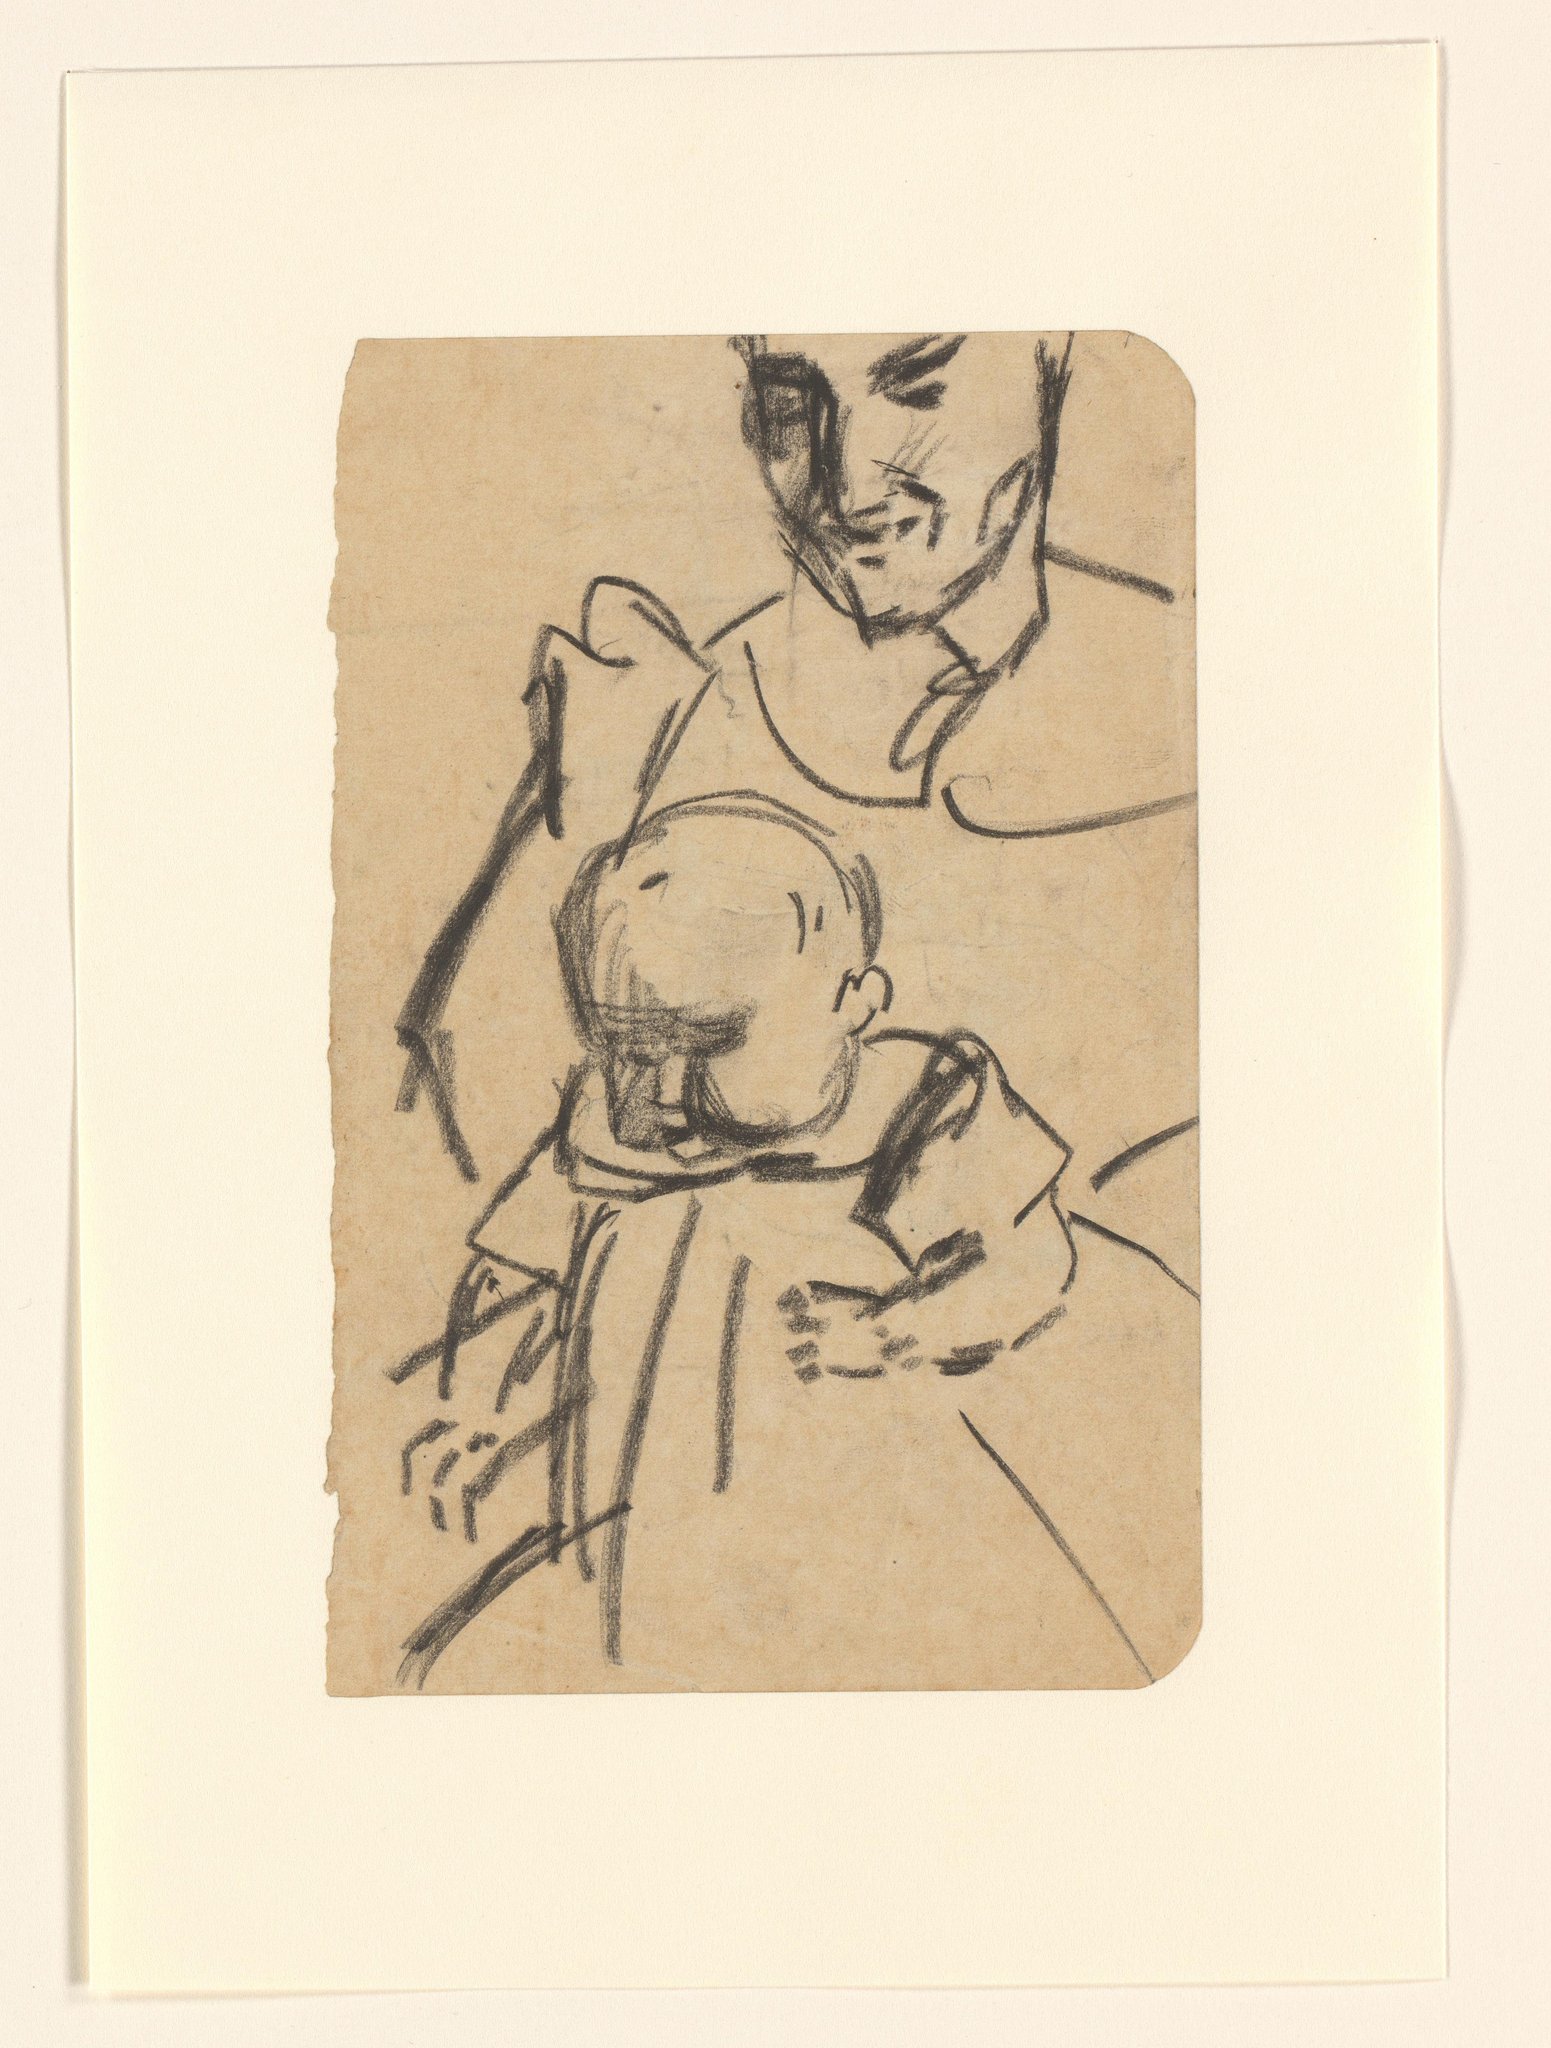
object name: drawing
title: Moeder met kind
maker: isaac israels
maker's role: draughtsman, painter, print maker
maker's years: 1865-1934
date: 1875-1934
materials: chalk, paper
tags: mother and baby or young child